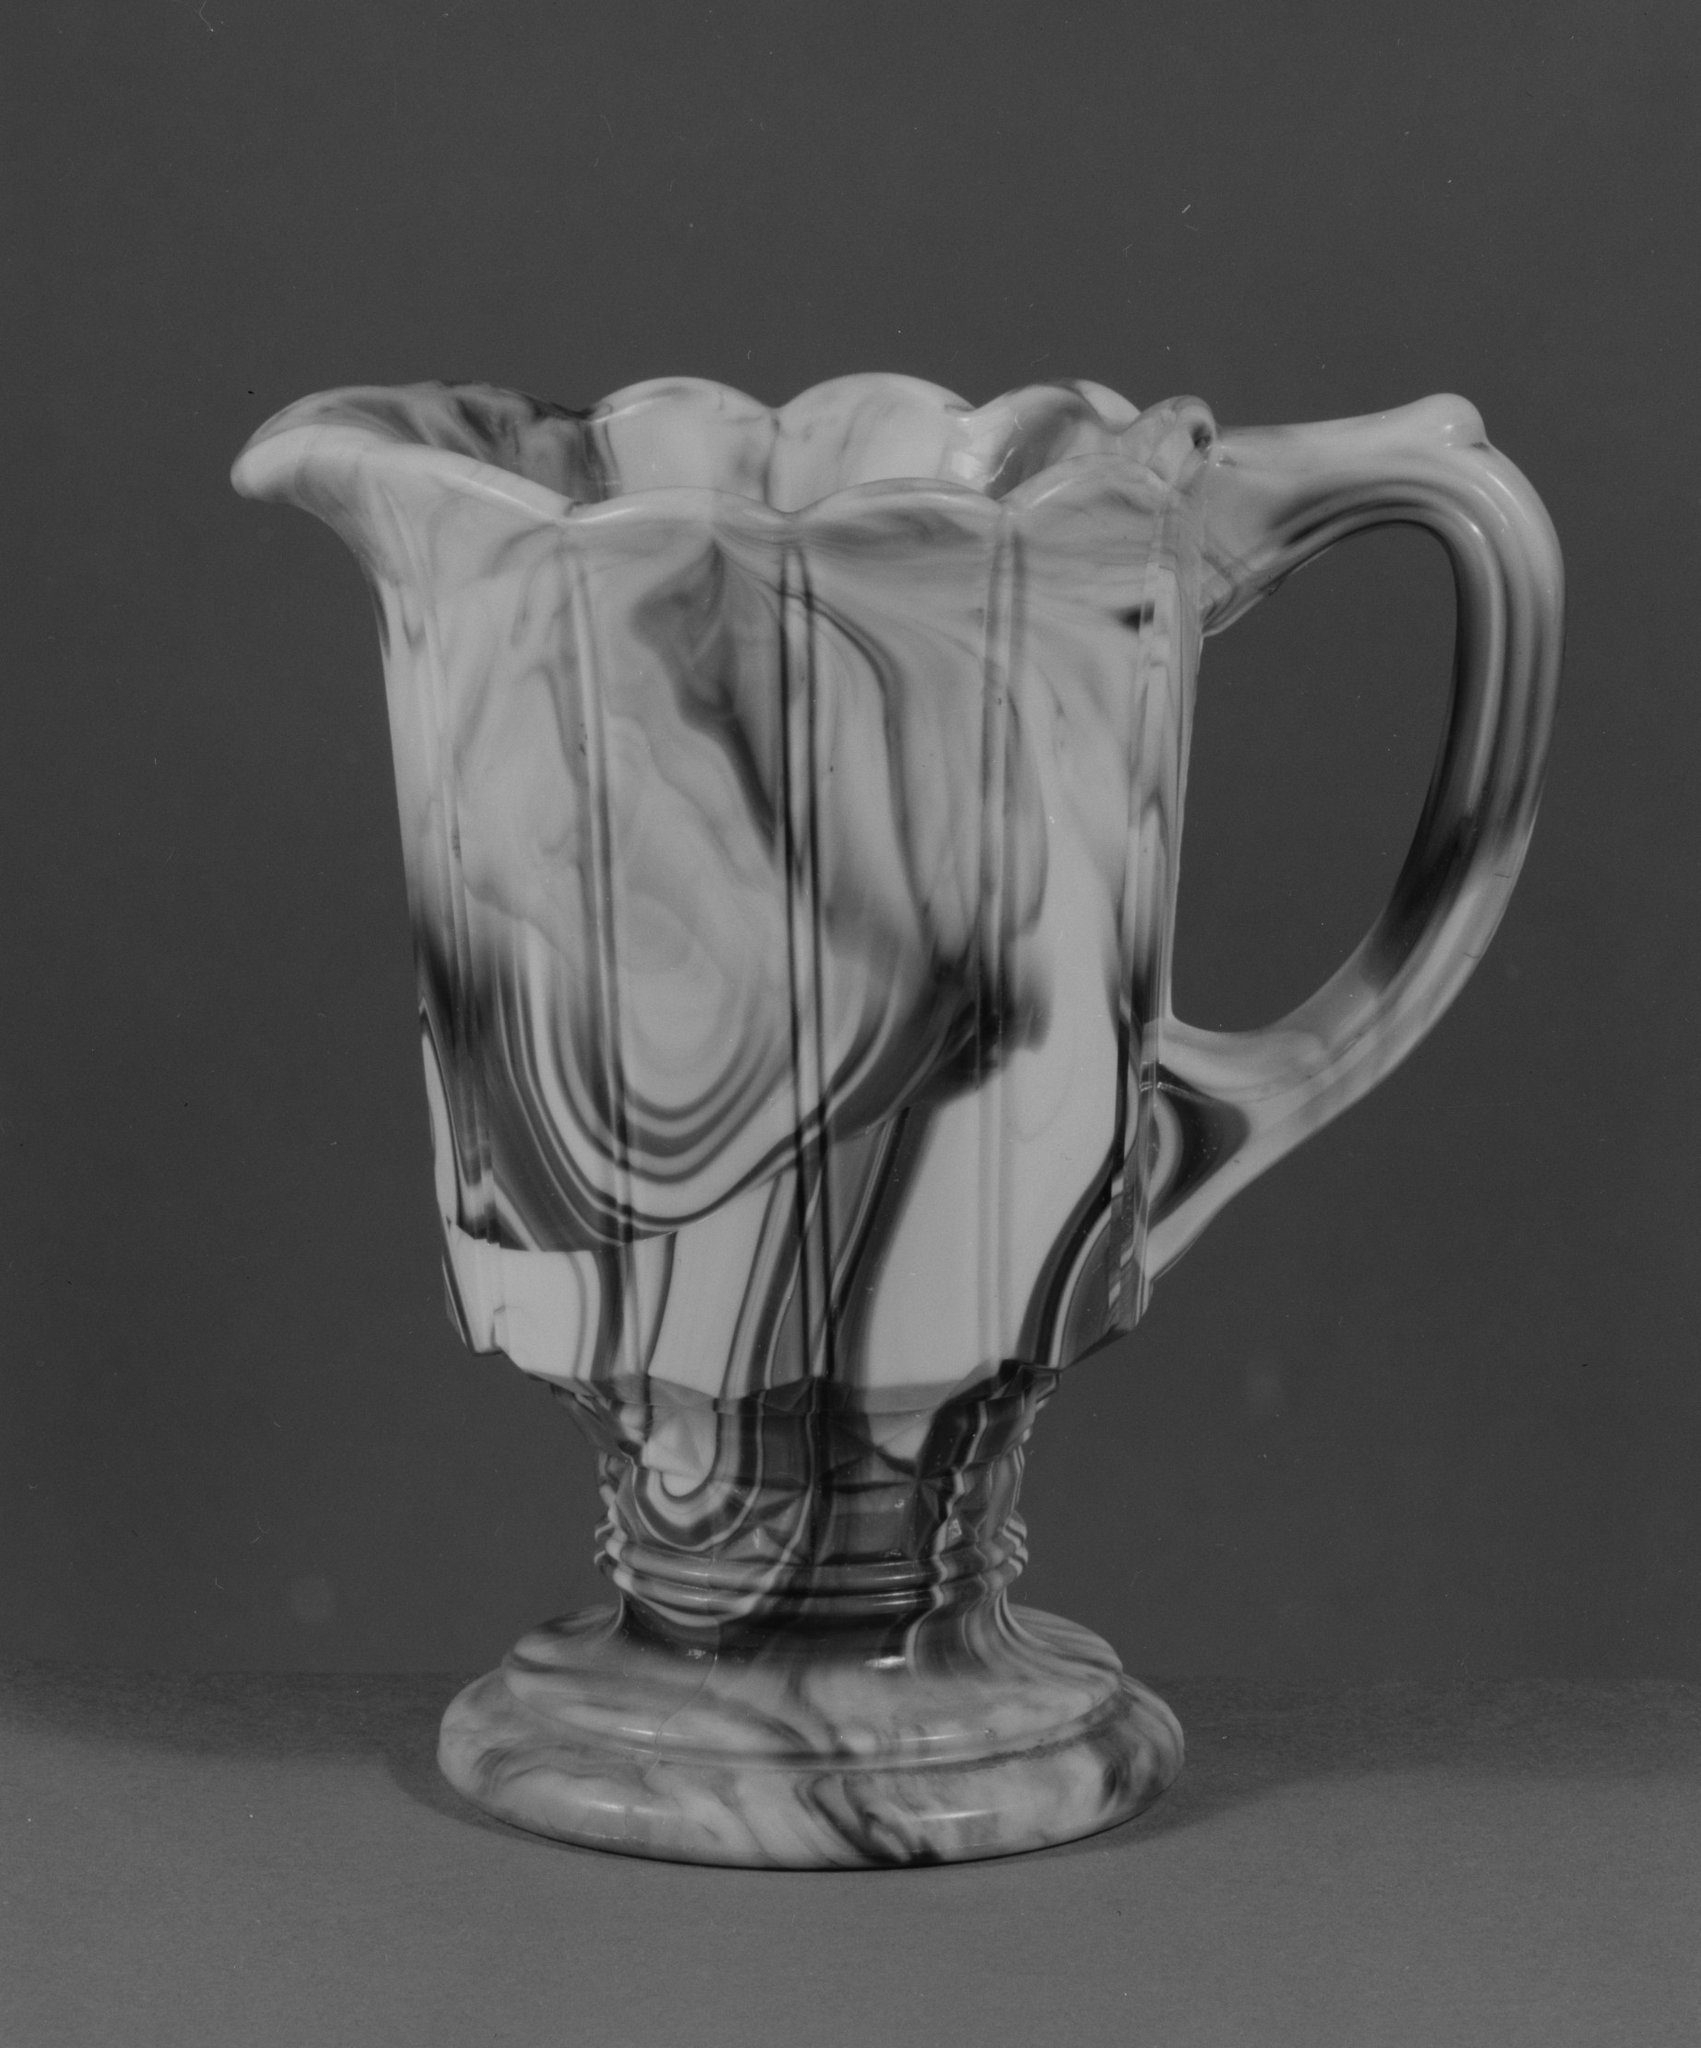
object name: cream pot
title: Creamer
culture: american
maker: challinor, taylor and company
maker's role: maker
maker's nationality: american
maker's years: 1866-1891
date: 1870-1890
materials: glass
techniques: pressed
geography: united states